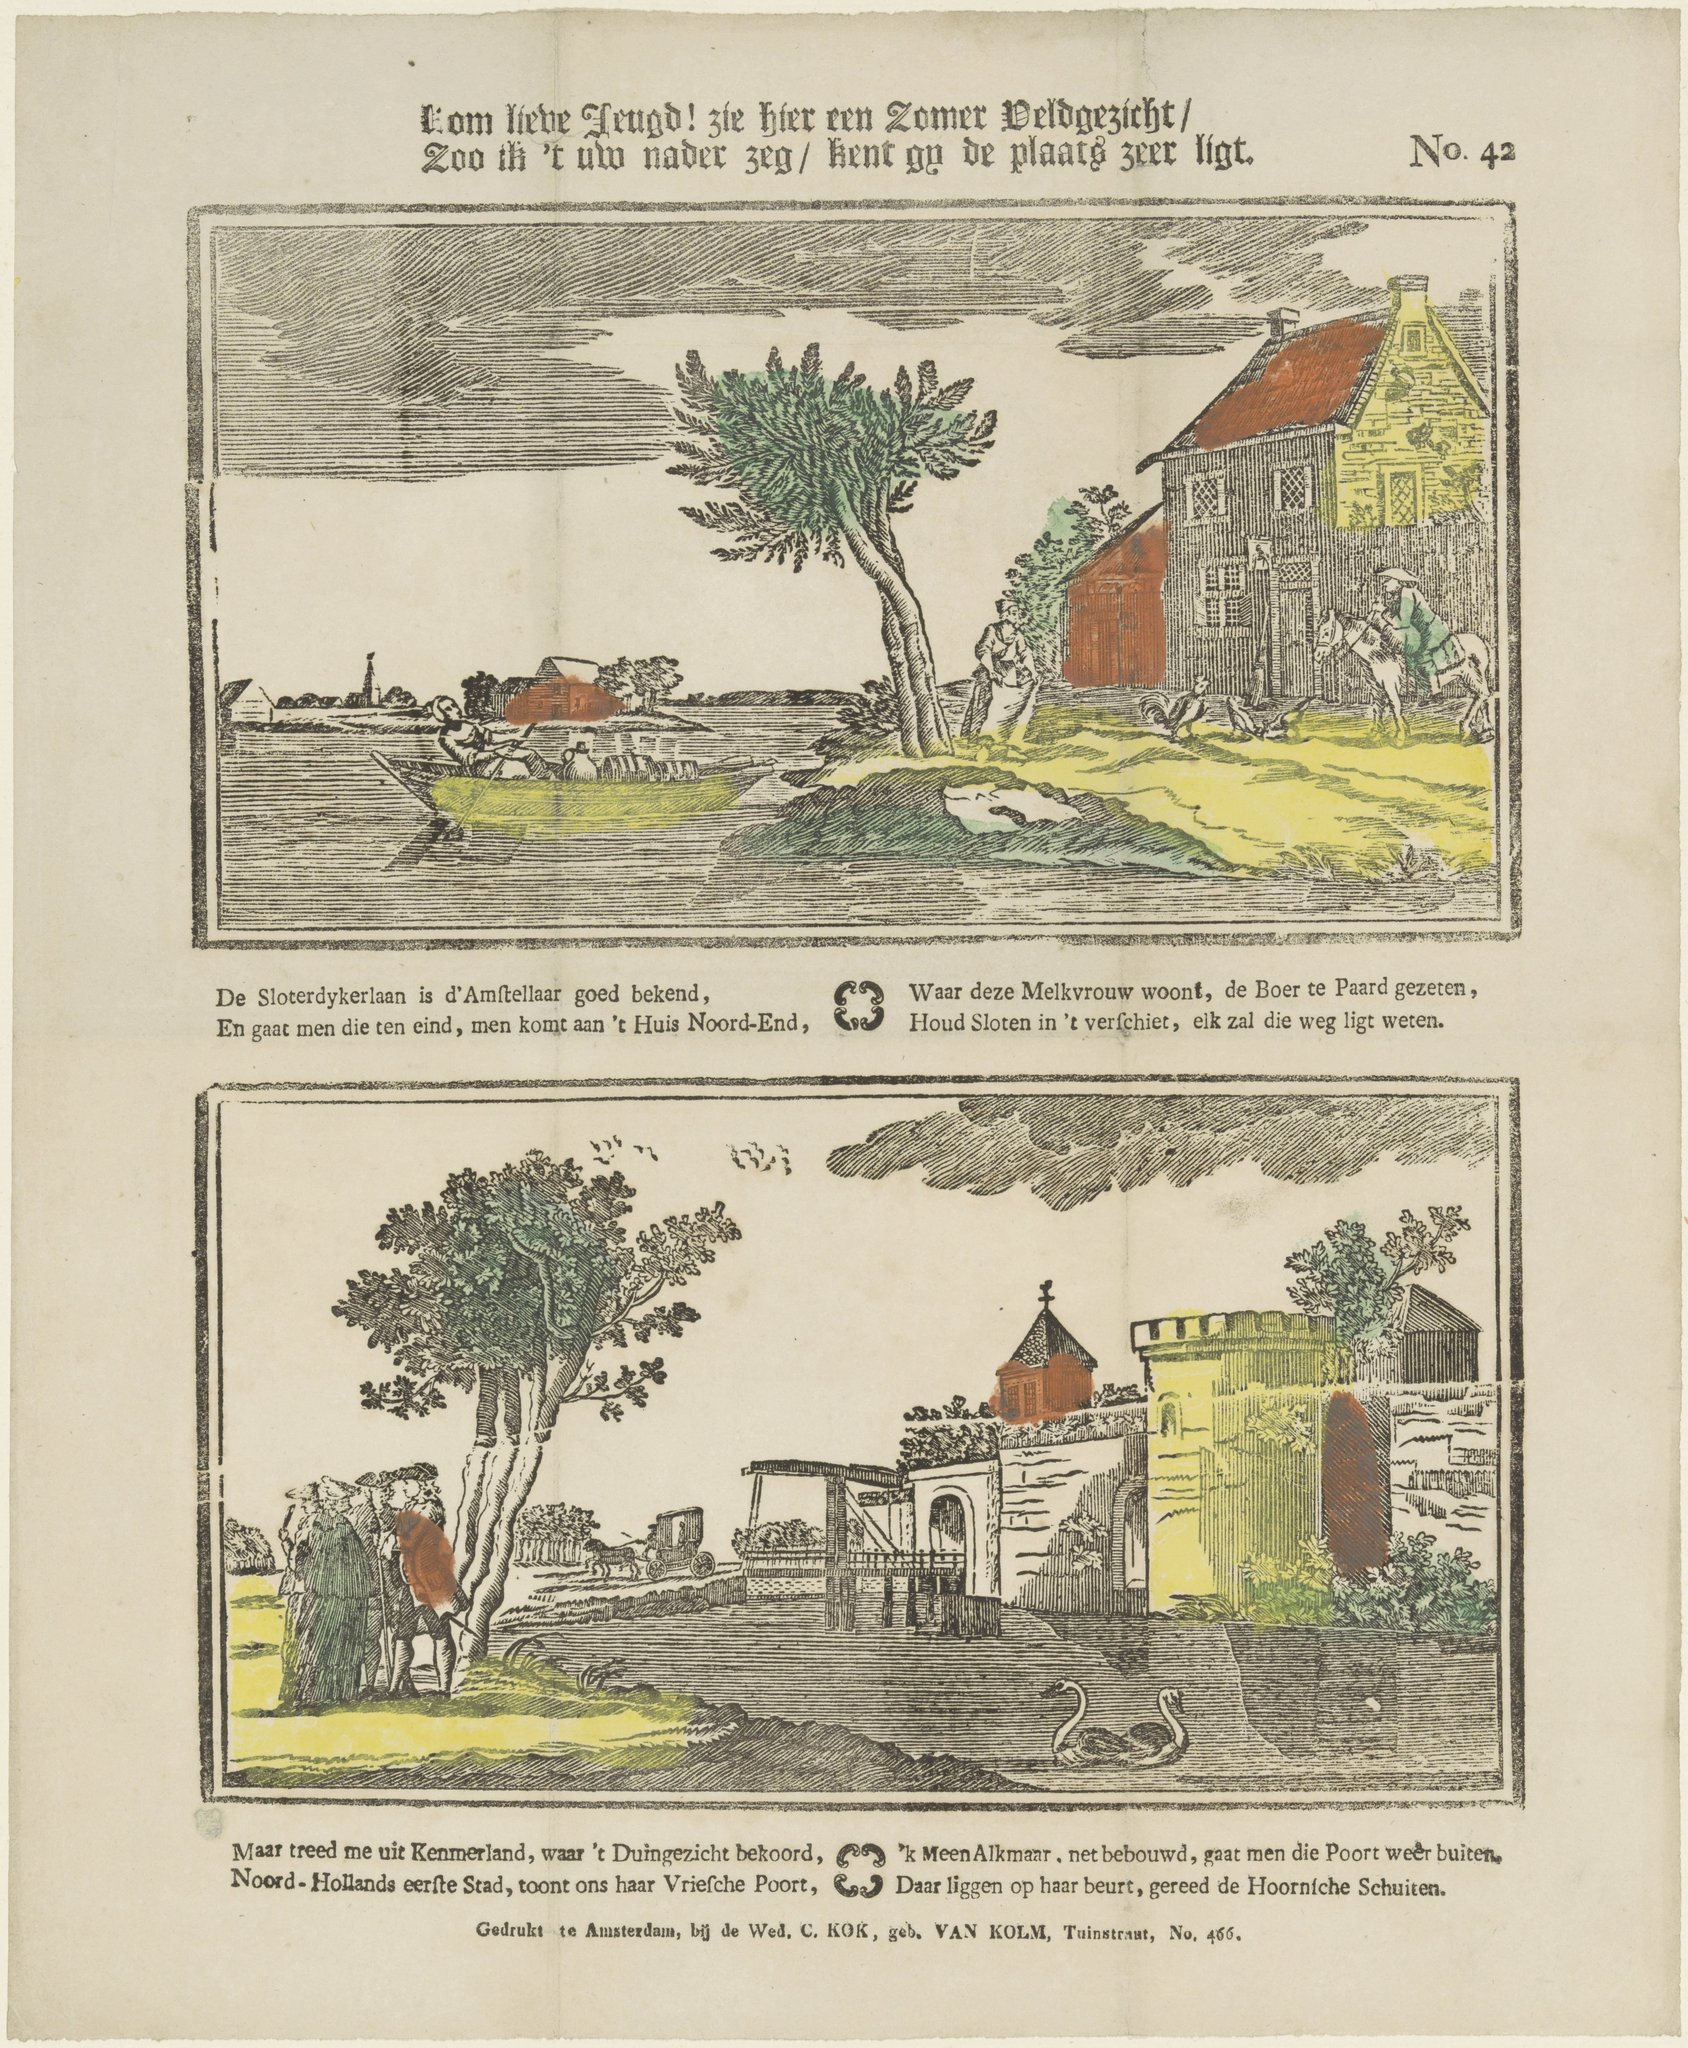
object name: print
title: Kom lieve jeugd! zie hier een zomer veldgezicht / Zoo ik 't uw nader zeg / kent gy de plaats zeer ligt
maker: weduwe c. kok geboren van kolm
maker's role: printer, publisher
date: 1842-1866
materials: paper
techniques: colour, letterpress printing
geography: amsterdam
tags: gate, entrance, transportation of milk, amsterdam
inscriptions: collector's mark: Lugt 2760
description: Blad met 2 voorstellingen. Boven: de melkerij Noord-End te Amsterdam. Onder: de Vrieschepoort te Alkmaar. Onder elke afbeelding een vierregelig vers. Genummerd rechtsboven: No. 42.